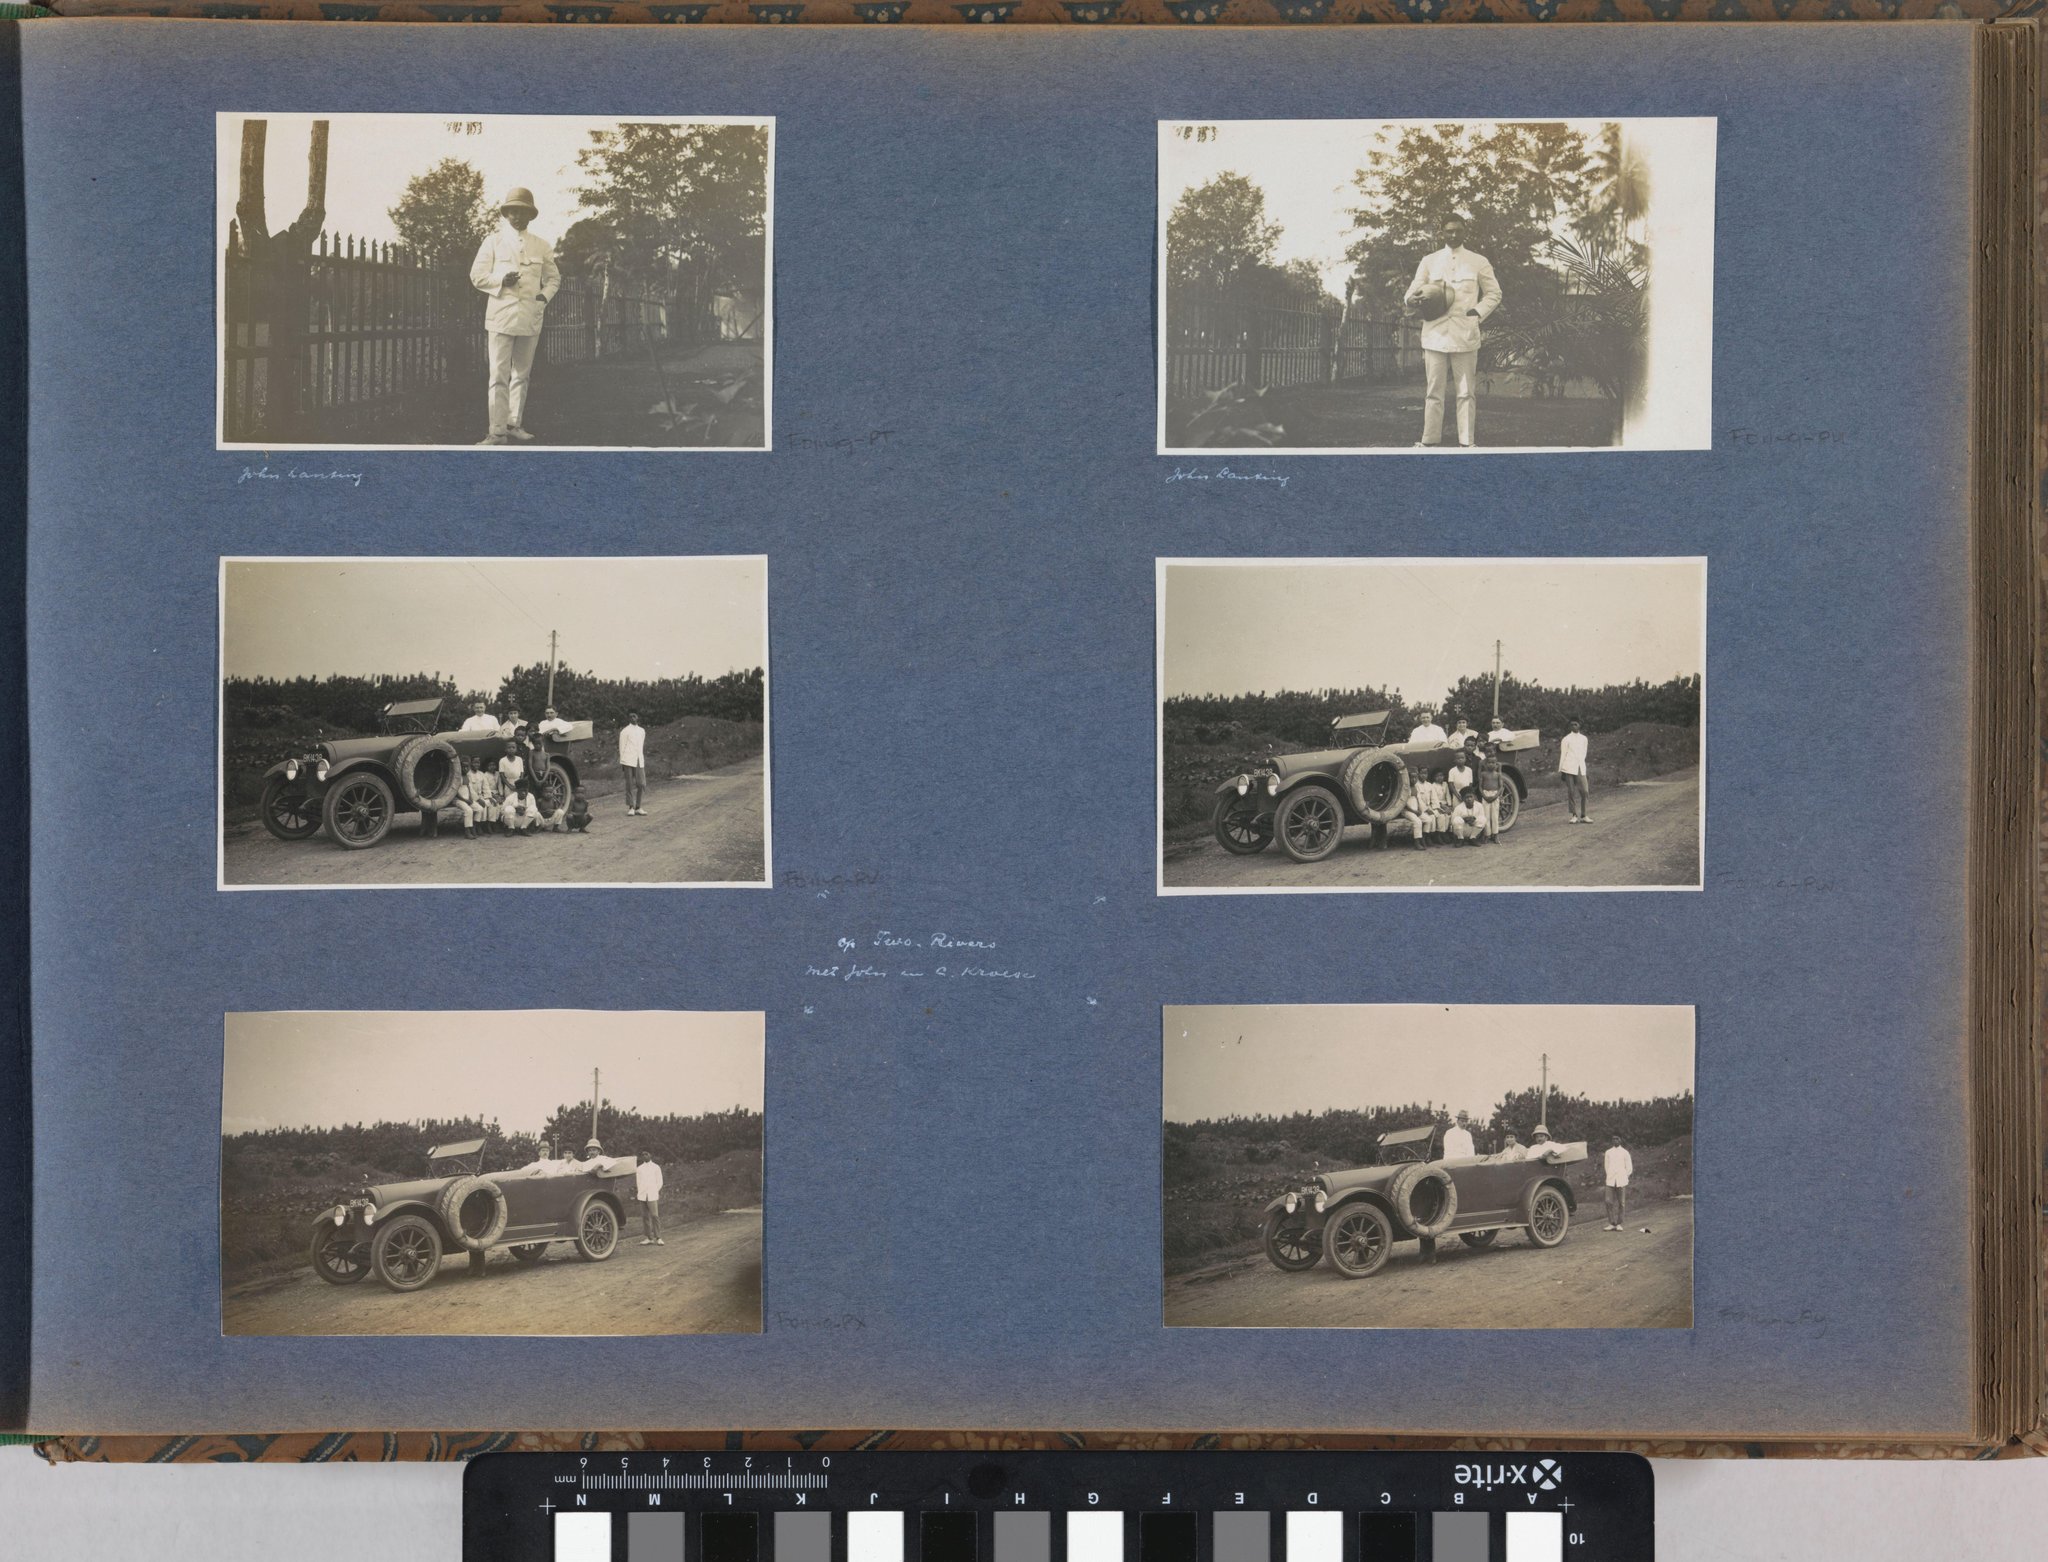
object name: album leaf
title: Man aangeduid als 'John Lanting' staand bij een hek, vermoedelijk op Sumatra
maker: Anonymous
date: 1900-1920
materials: paper, photographic support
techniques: gelatin silver print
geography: sumatra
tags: plantation, fence, wall, paling, adult man, sumatra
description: Onderdeel van reisalbum met foto's van bedrijvigheid en bezienswaardigheden op Sumatra en Java en van de reis naar en van Nederlands-Indië.